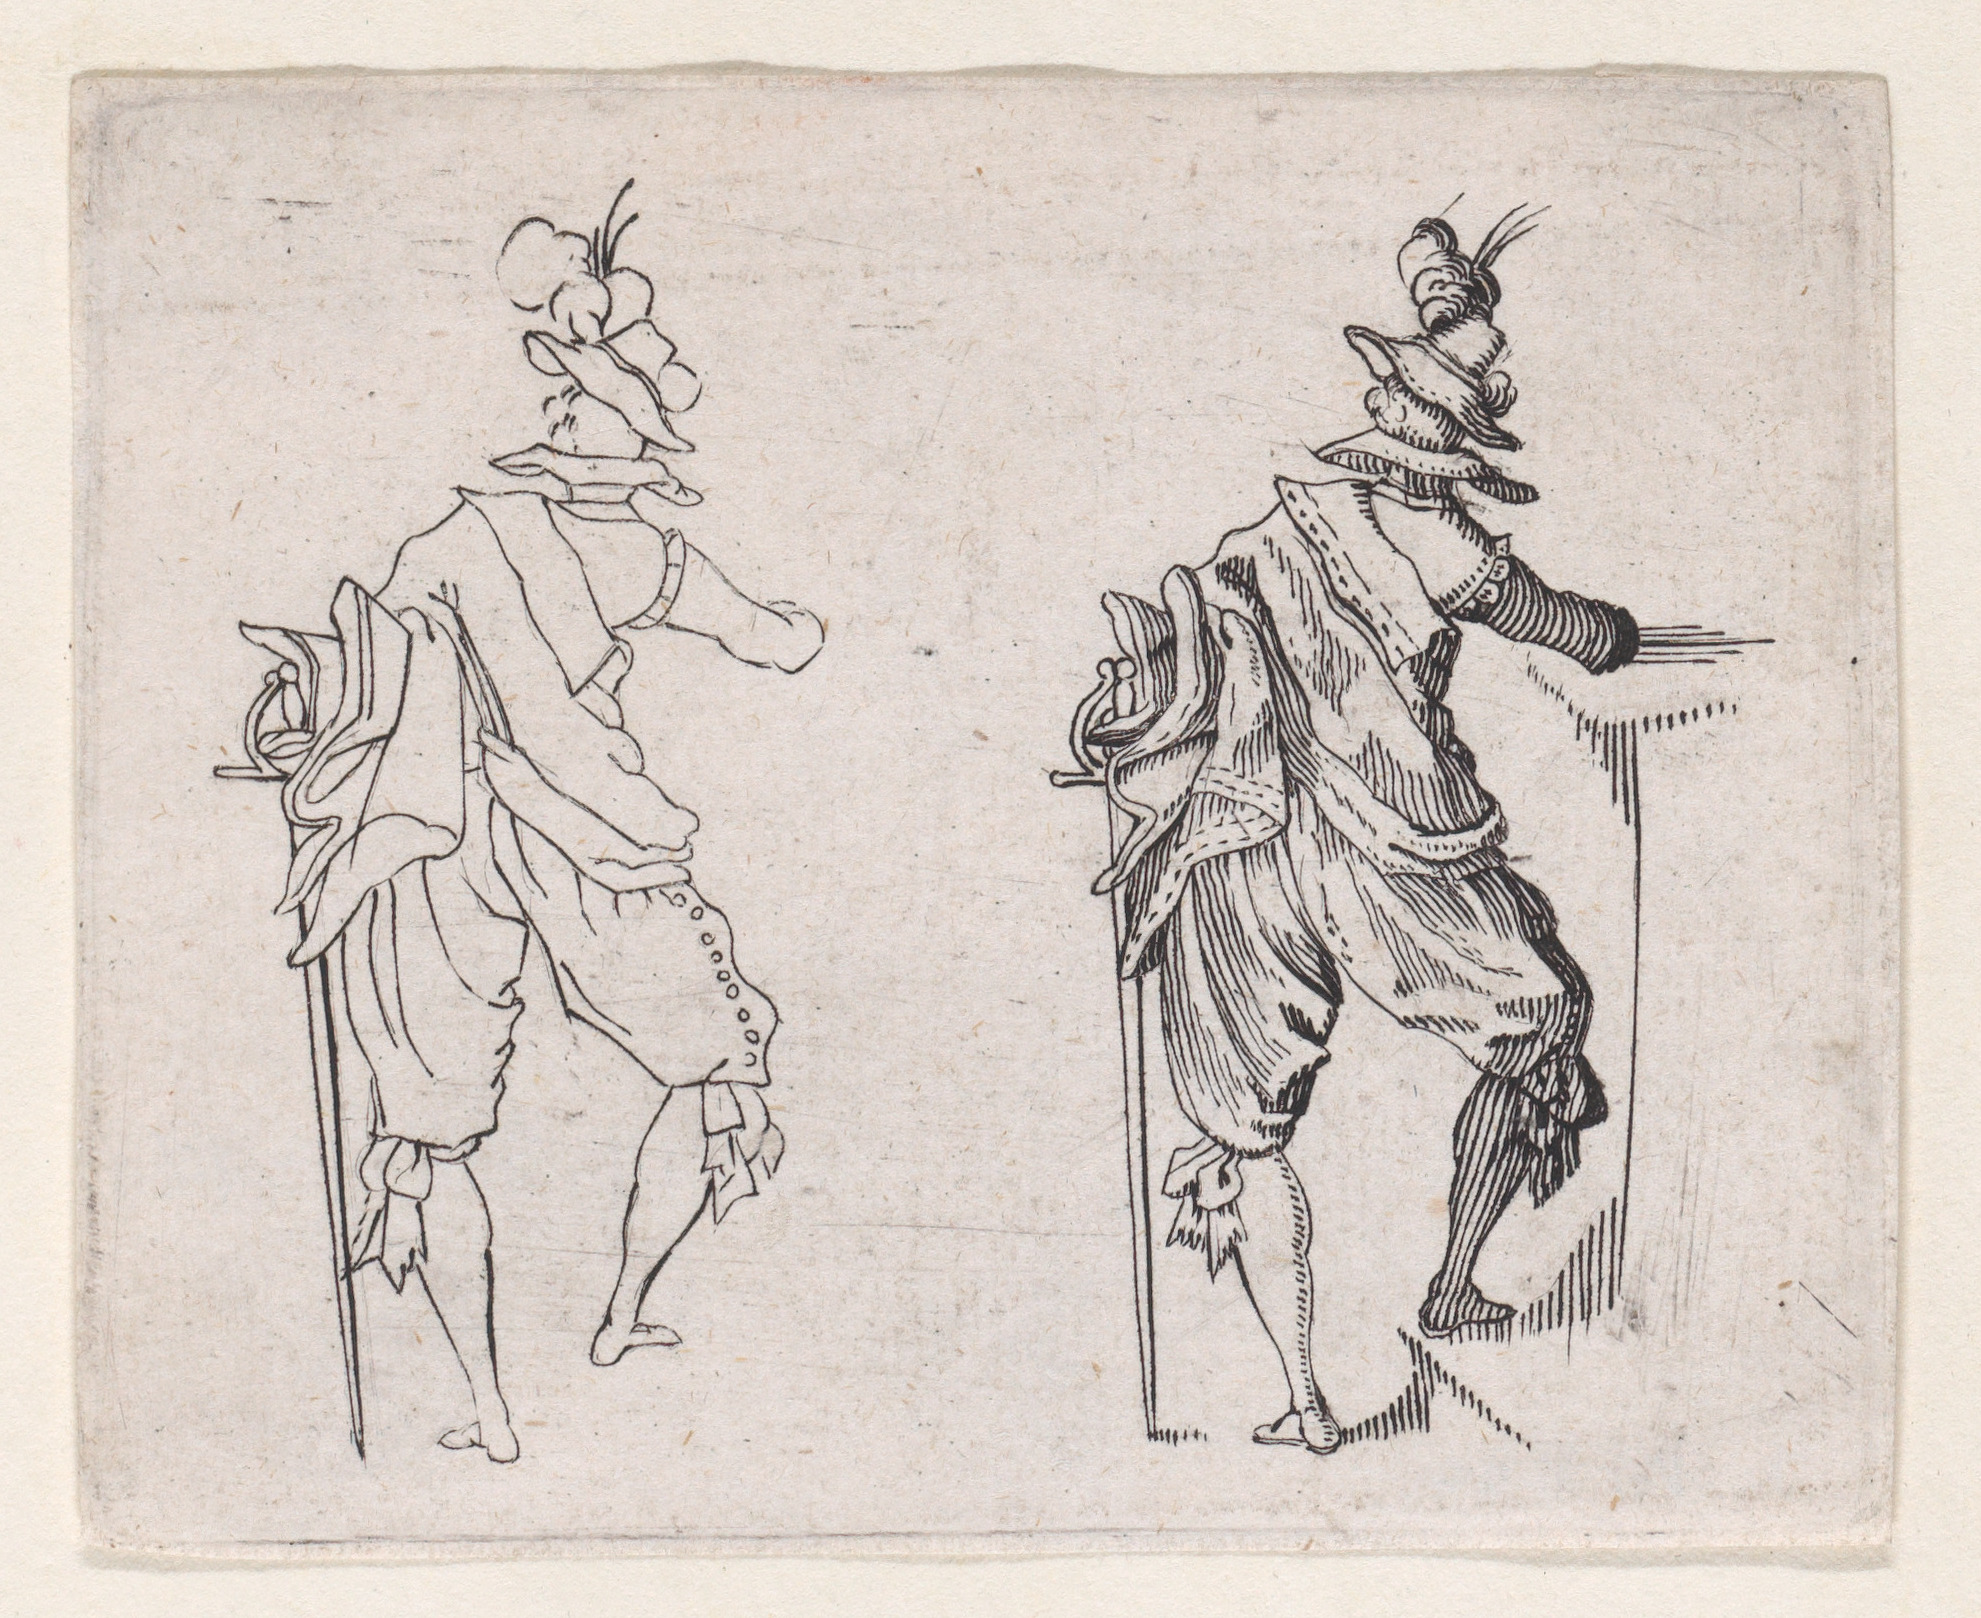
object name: print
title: Copy of L'Homme Vu de Dos, Avec un Grand Épée (Man Viewed from Behind, With a Large Sword), from "Les Caprices" Series A, The Florence Set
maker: Anonymous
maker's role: artist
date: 1601-1700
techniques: etching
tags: men